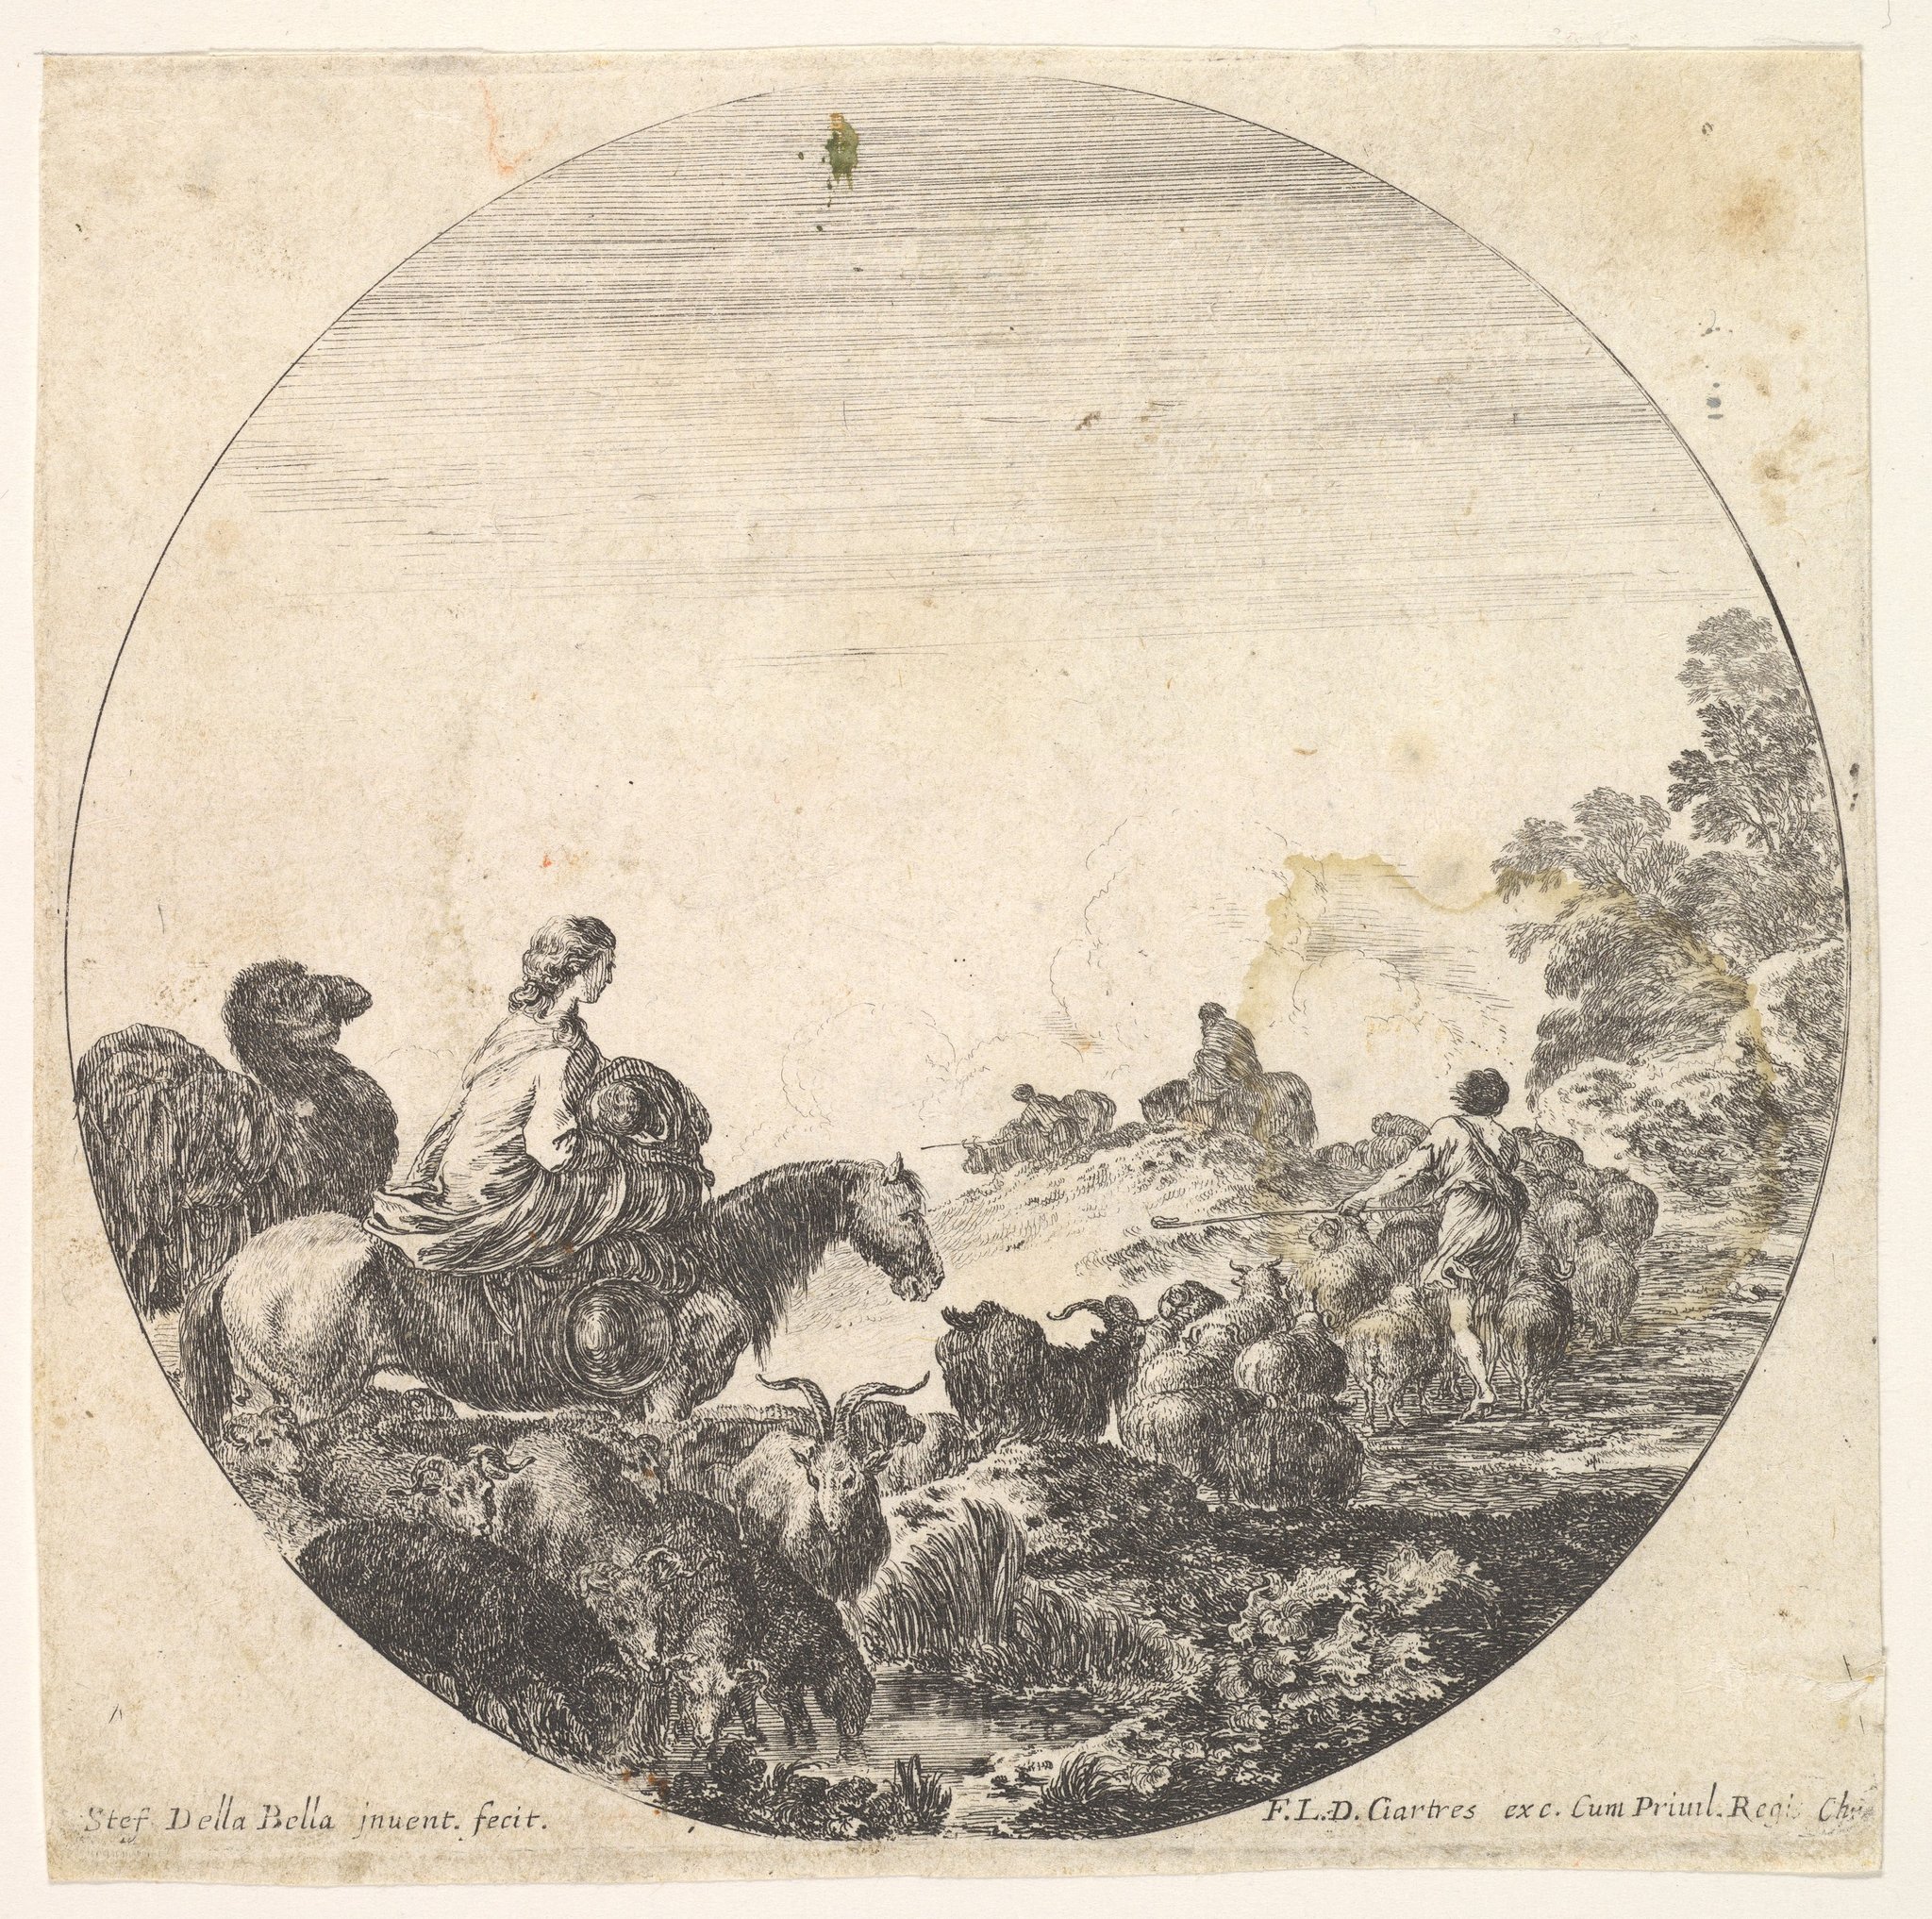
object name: print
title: Plate 5: a woman carrying a child on a horse to left, a camel following her, a herd of goats, sheep, and a shepherd in front of her to right, from "Roman landscapes and ruins" (Paysages et ruines de Rome)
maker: stefano della bella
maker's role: artist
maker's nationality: italian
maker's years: 1610-1664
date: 1643-1648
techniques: etching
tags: women,camels,goats,sheep,shepherds